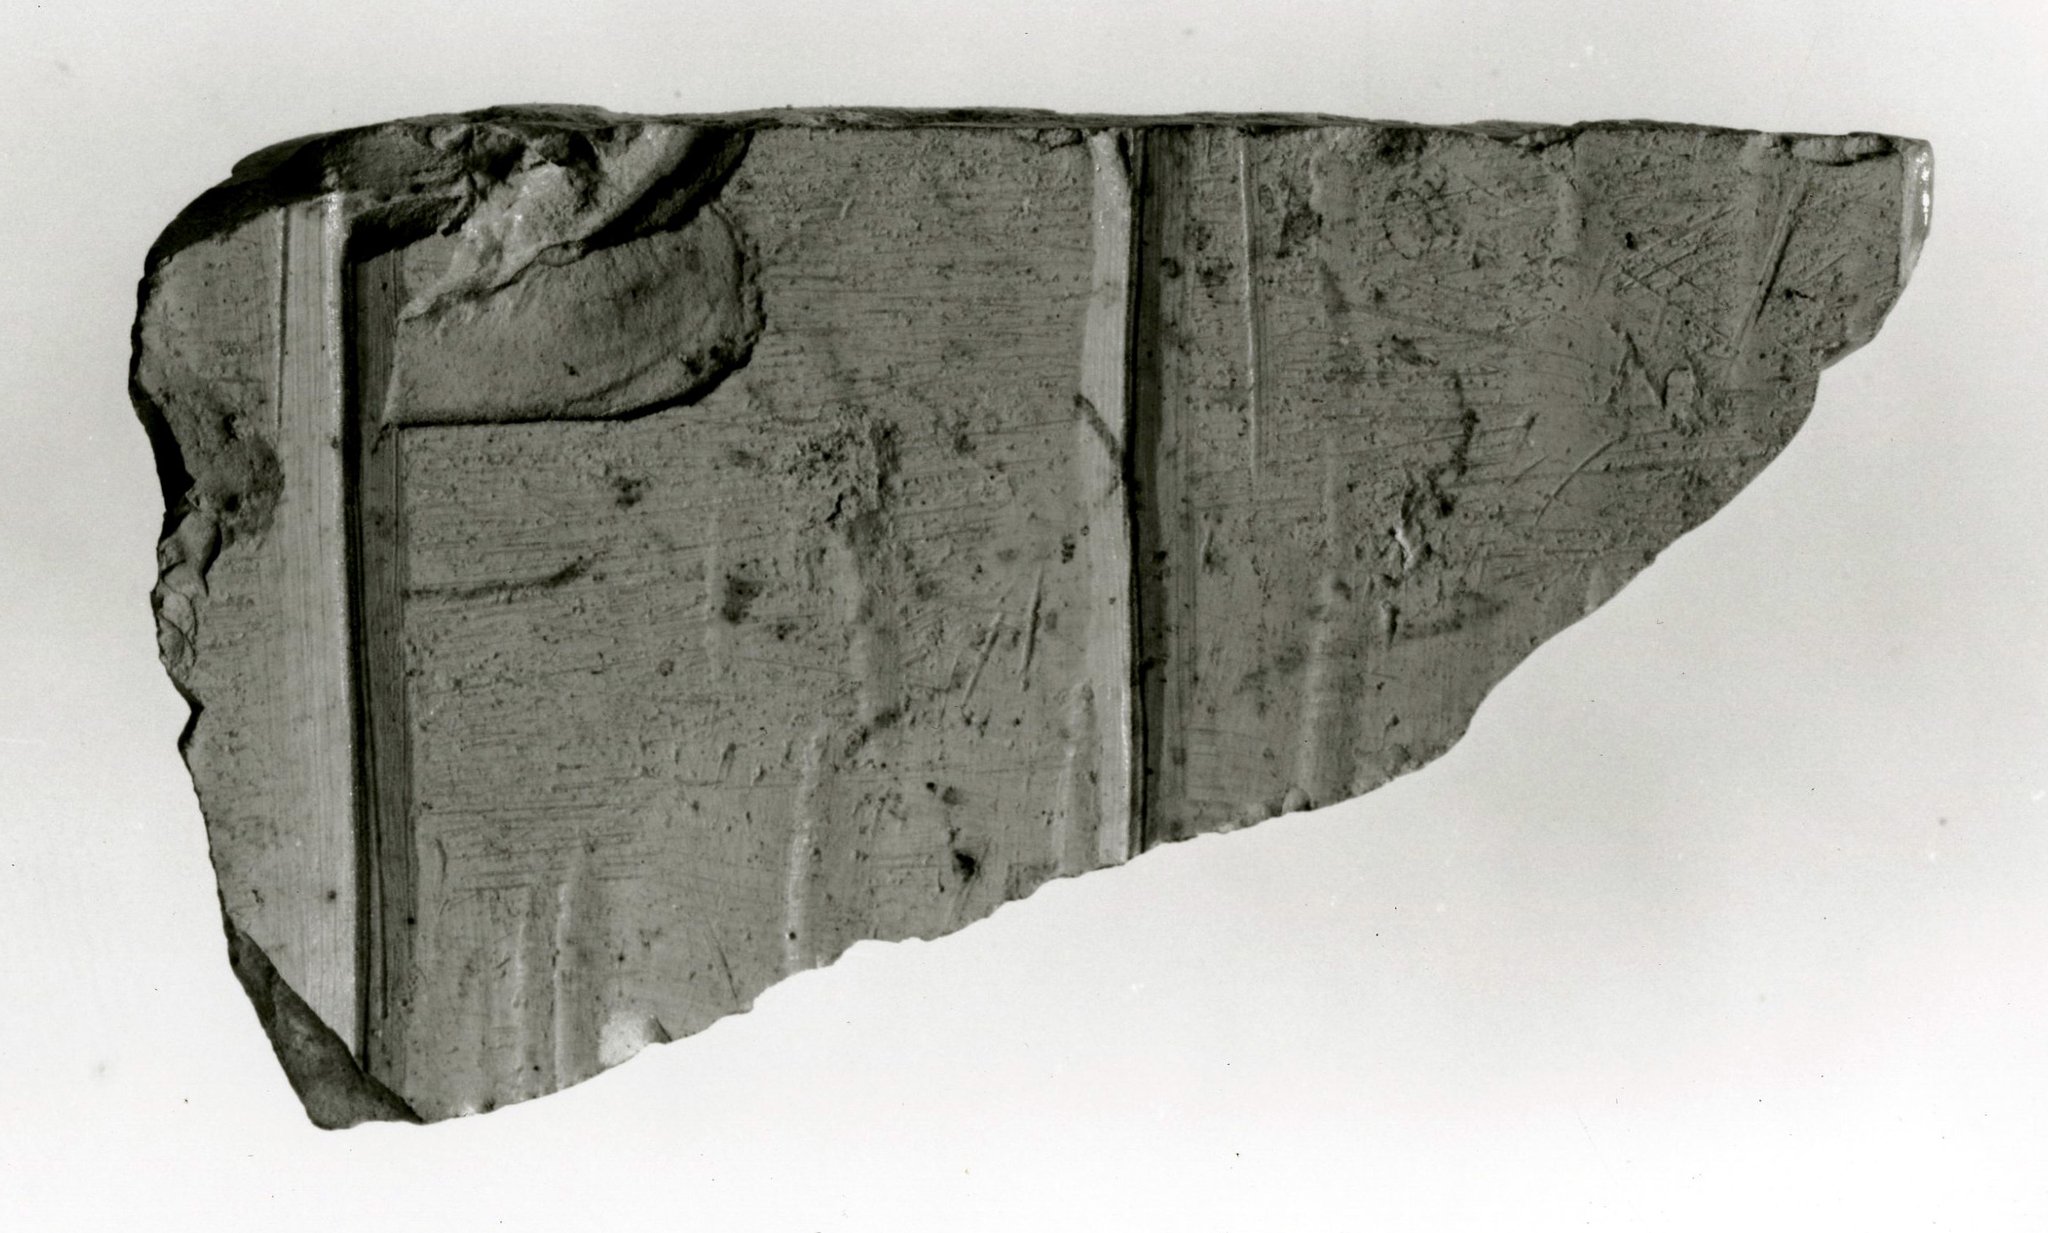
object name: relief, tomb of nespekashuty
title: Raised relief fragment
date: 664-610 BCE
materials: limestone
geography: egypt